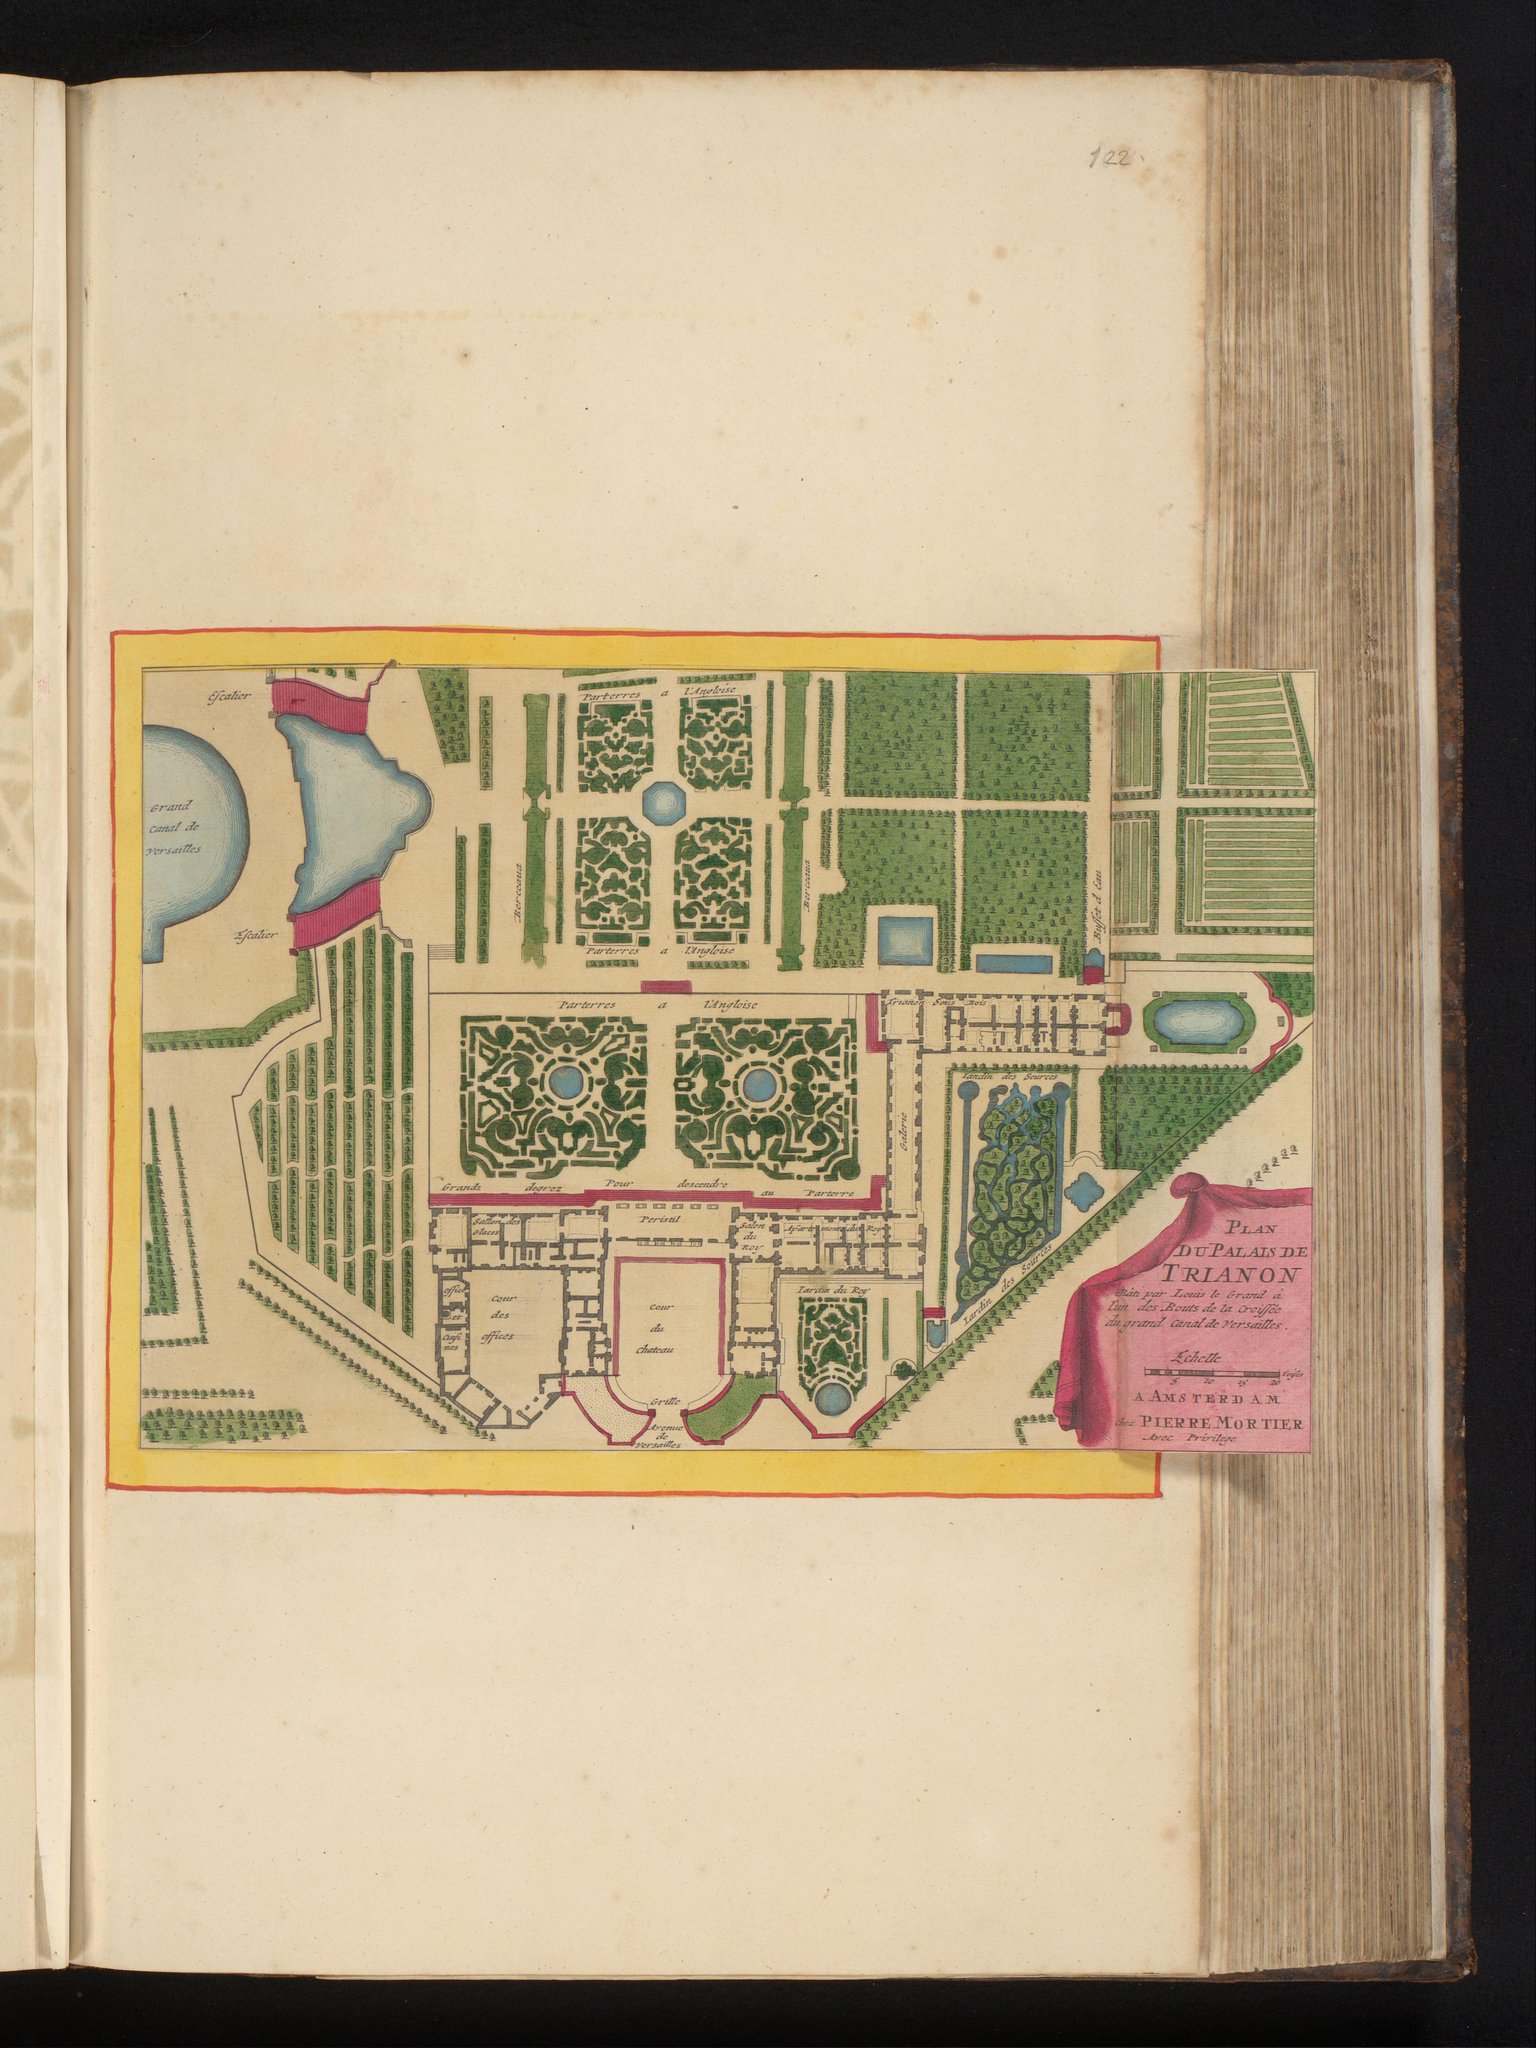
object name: print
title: Plattegrond van de Grote Trianon met tuinen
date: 1685-1712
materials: paper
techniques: etching, hand coloring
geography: amsterdam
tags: french or architectonic garden; formal garden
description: Plattegrond van het paleis de Grote Trianon met bijbehorende tuinen, gelegen in de tuinen van het paleis van Versailles. Prent maakt deel uit van een album.